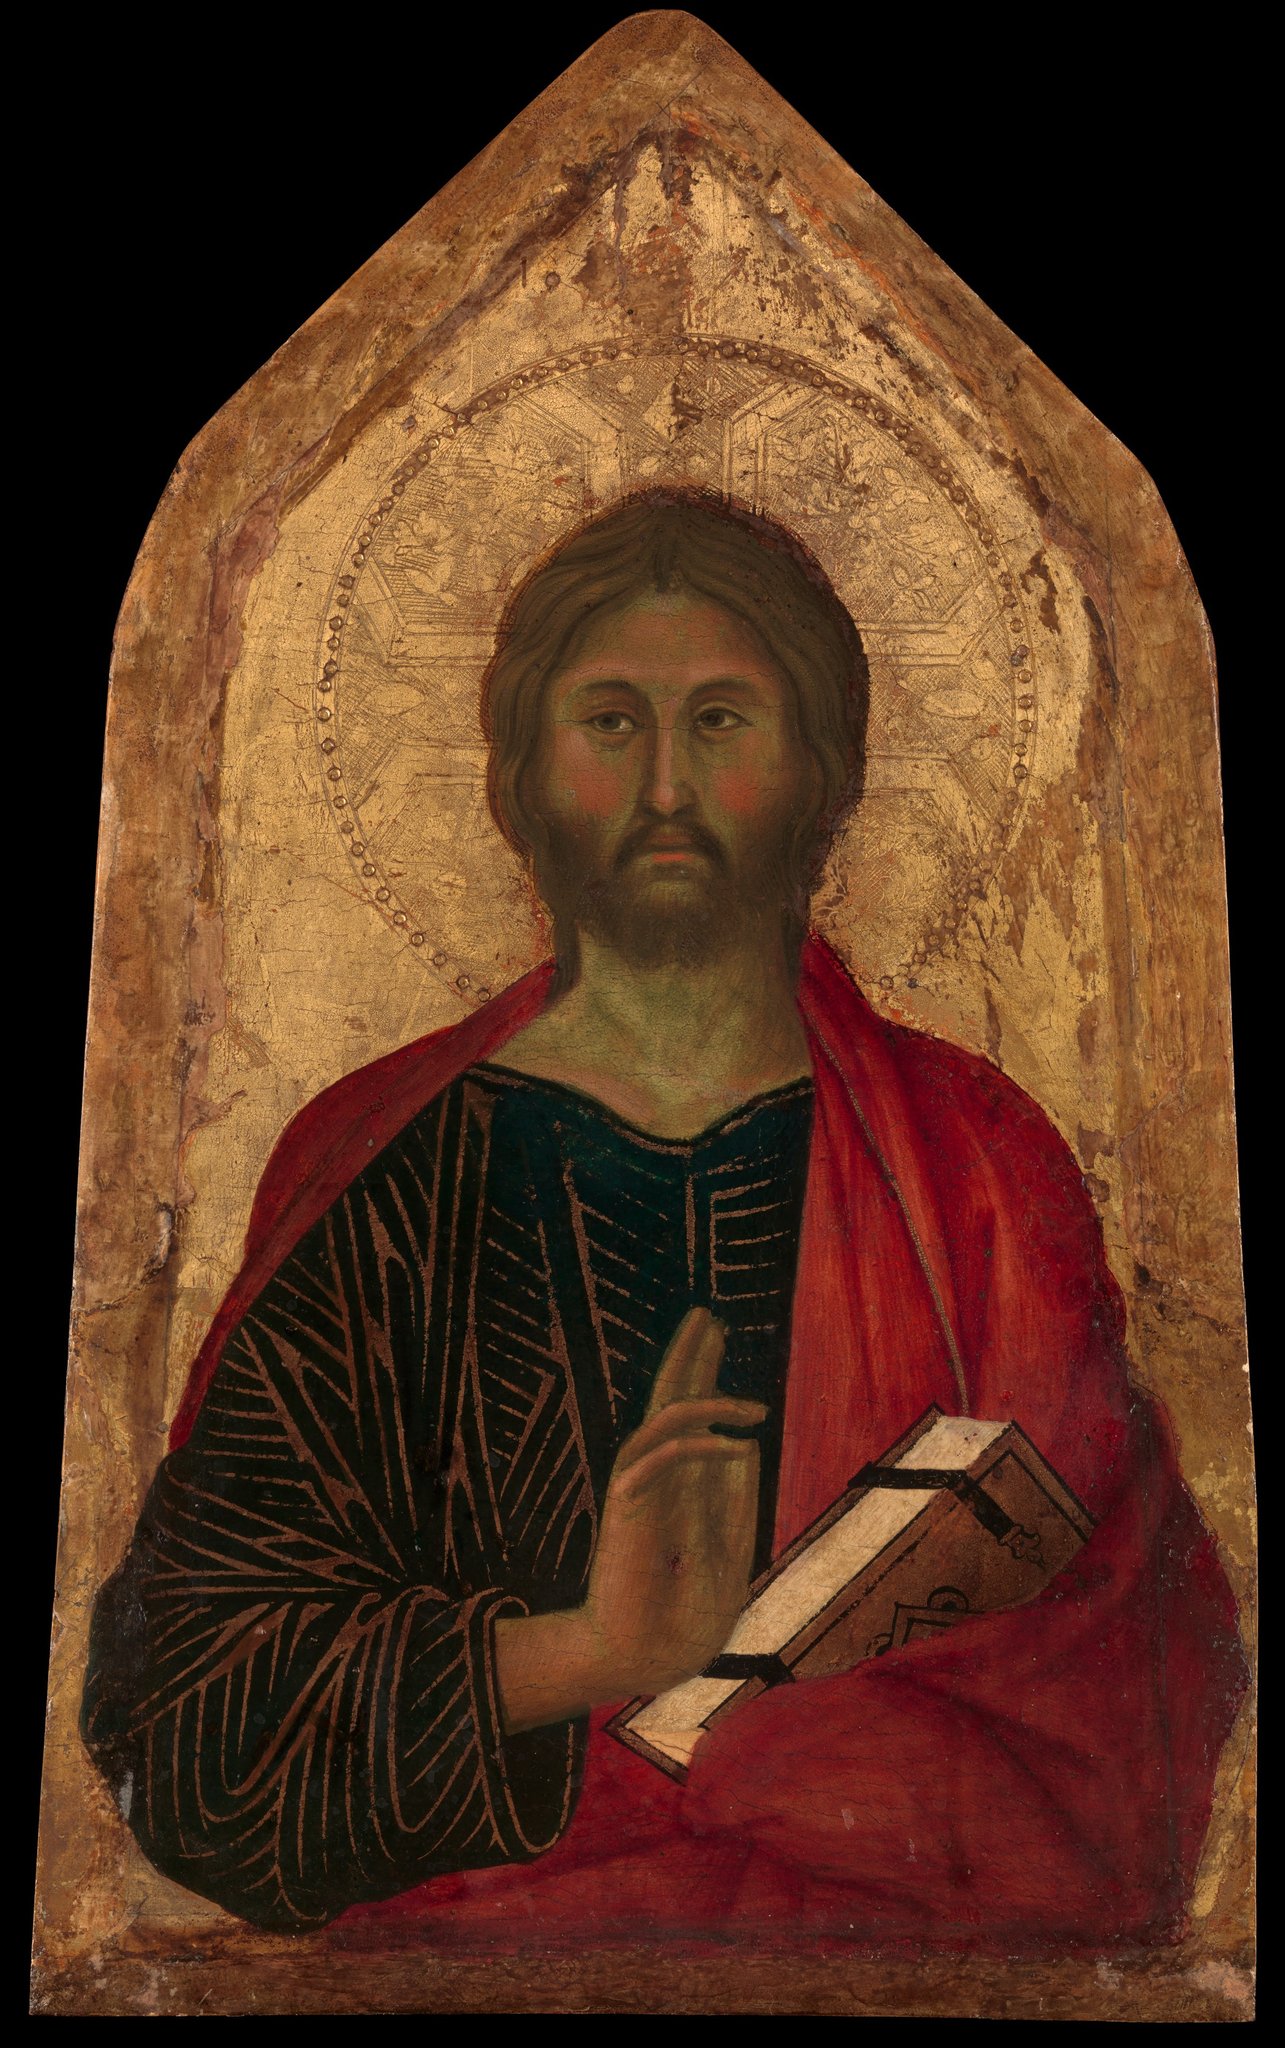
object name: painting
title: Christ Blessing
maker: segna di buonaventura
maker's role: artist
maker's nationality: italian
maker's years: 1298-1331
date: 1311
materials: gold leaf, paint, wood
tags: books,christ